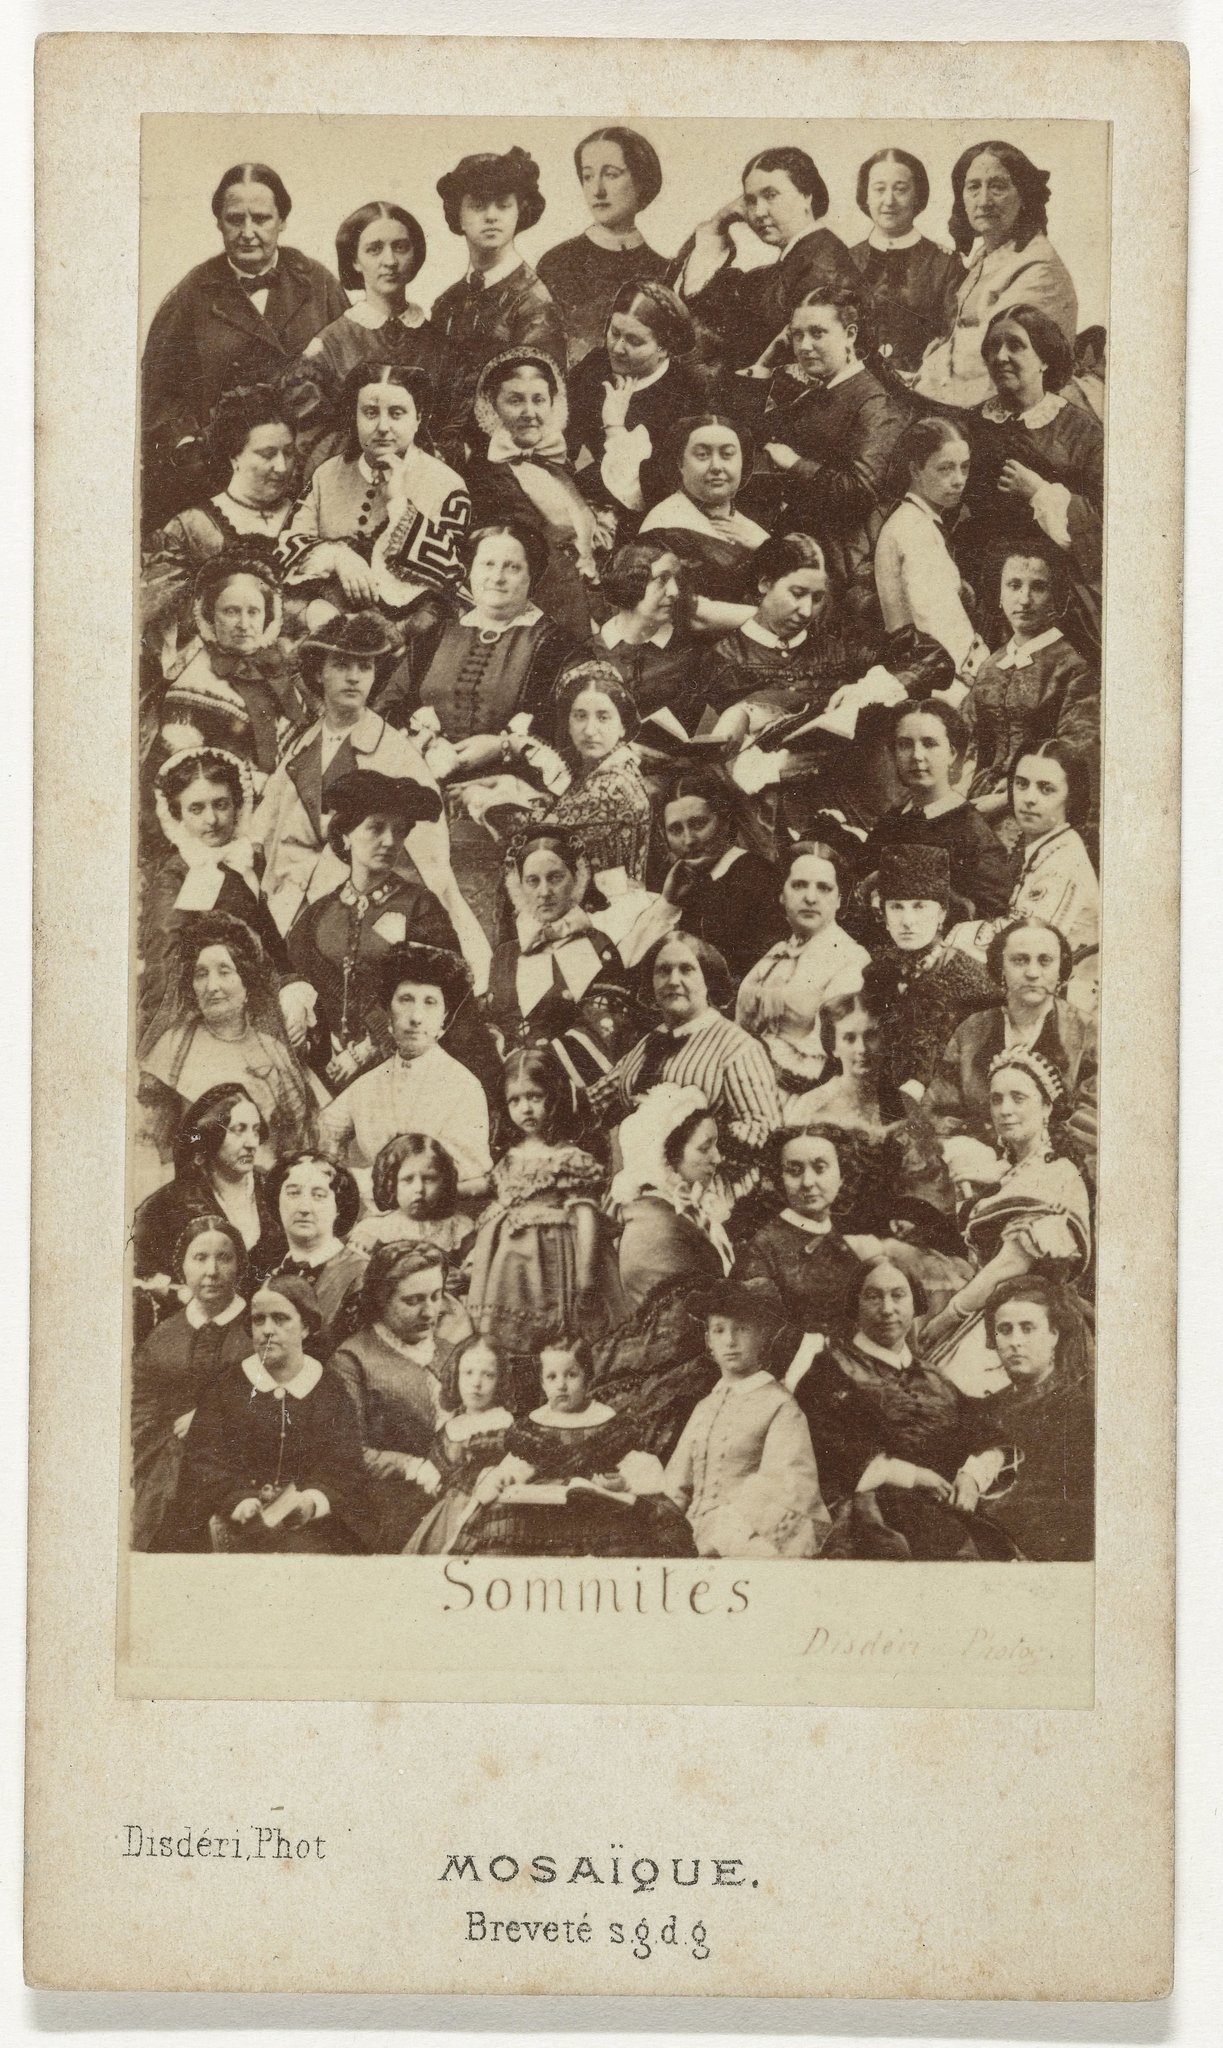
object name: photograph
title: Verzameling ('mosaïque') van portretten van bekende vrouwen ('Sommités'), Frankrijk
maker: andré-adolphe-eugène disdéri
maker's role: fotograaf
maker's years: 1819-1889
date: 1858-1870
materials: paper, photographic support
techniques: albumen print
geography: france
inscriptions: annotation: ‘Disdéri, Phot / MOSAÏQUE. / Breveté s.g.d.g.’, annotation: ‘DISDÉRI / PHOTOGRAPHE de S M L'EMPEREUR / 8, Boulevart des Italiens / PARIS’, annotation: ‘Sommités / Disdéri Photog.’